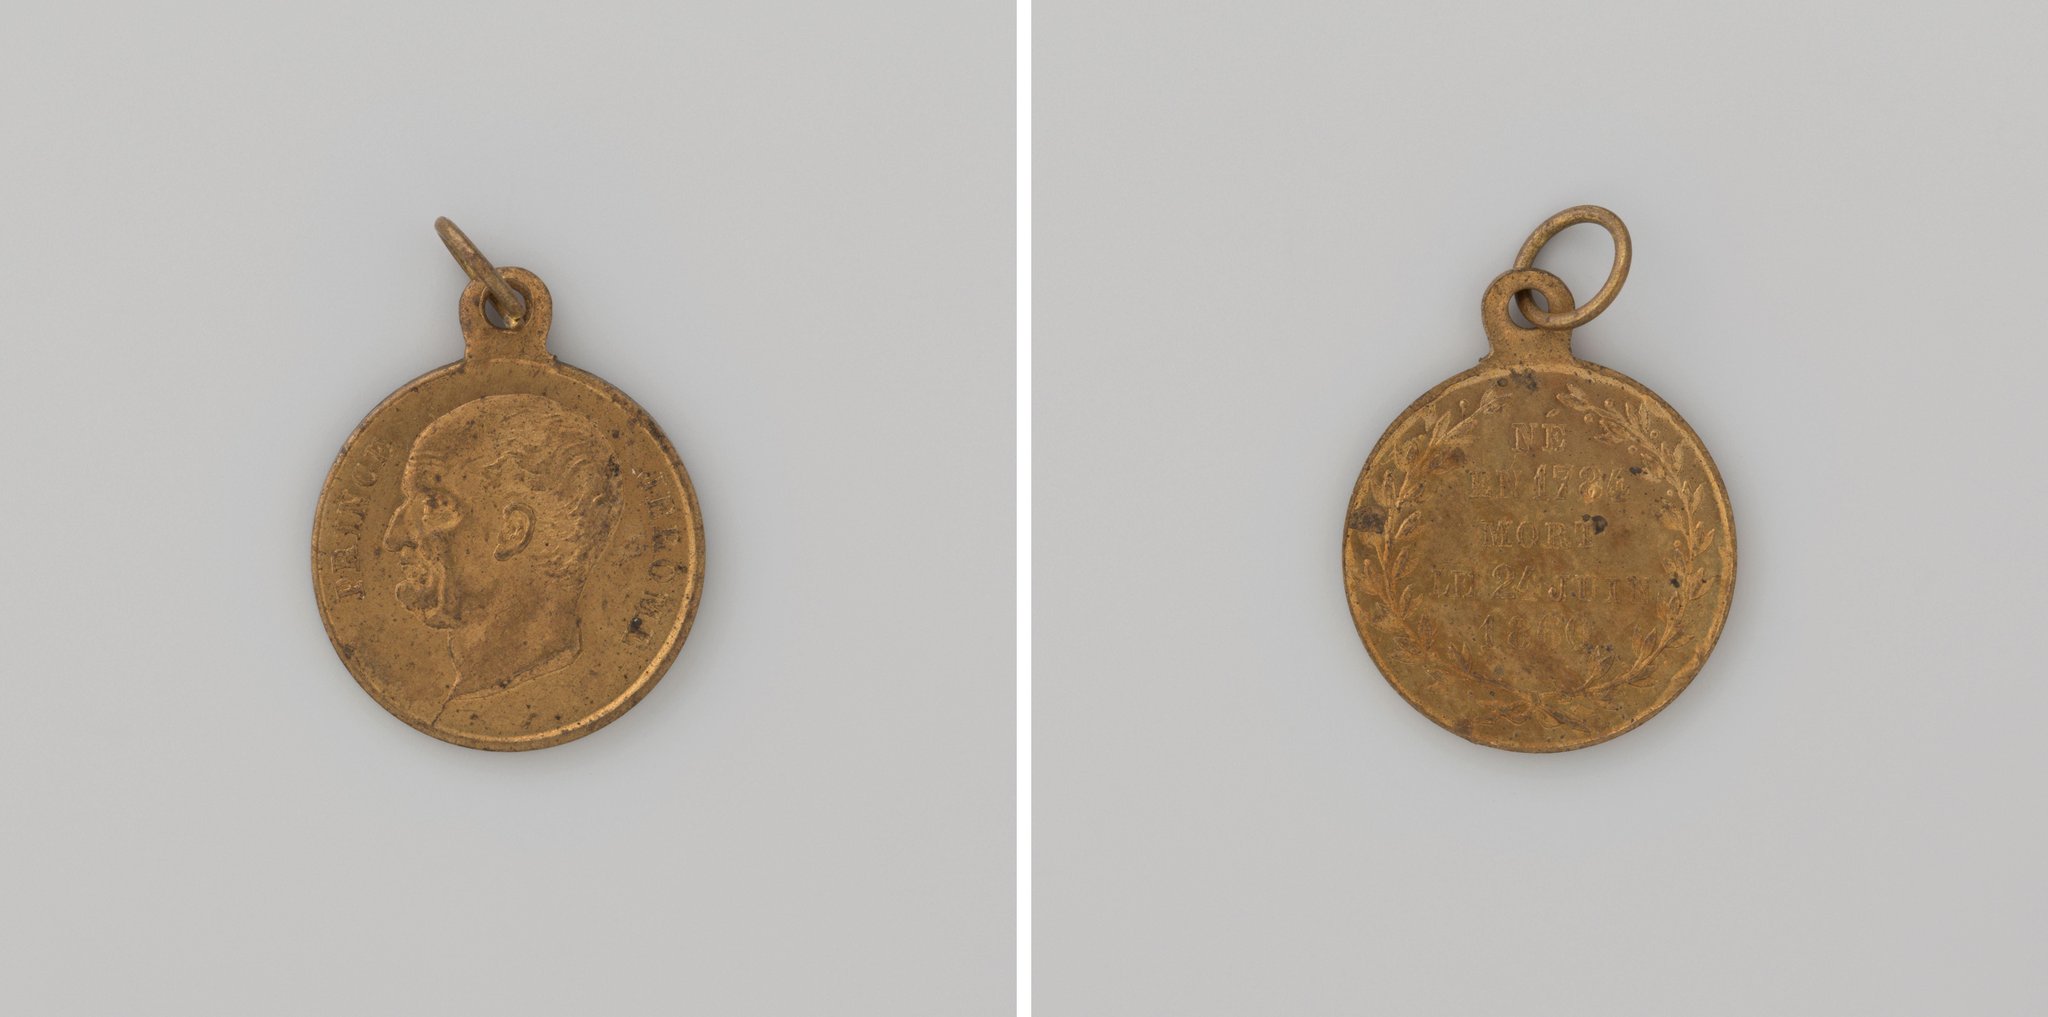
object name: history medal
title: Jerome Bonaparte, koning van Westfalen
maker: Anonymous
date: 1860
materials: metal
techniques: gilding, striking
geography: france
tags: paris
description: penning aan draagoog en draagring. Voorzijde: borststuk man binnen omschrift. Keerzijde: opschrift binnen lauwerkrans